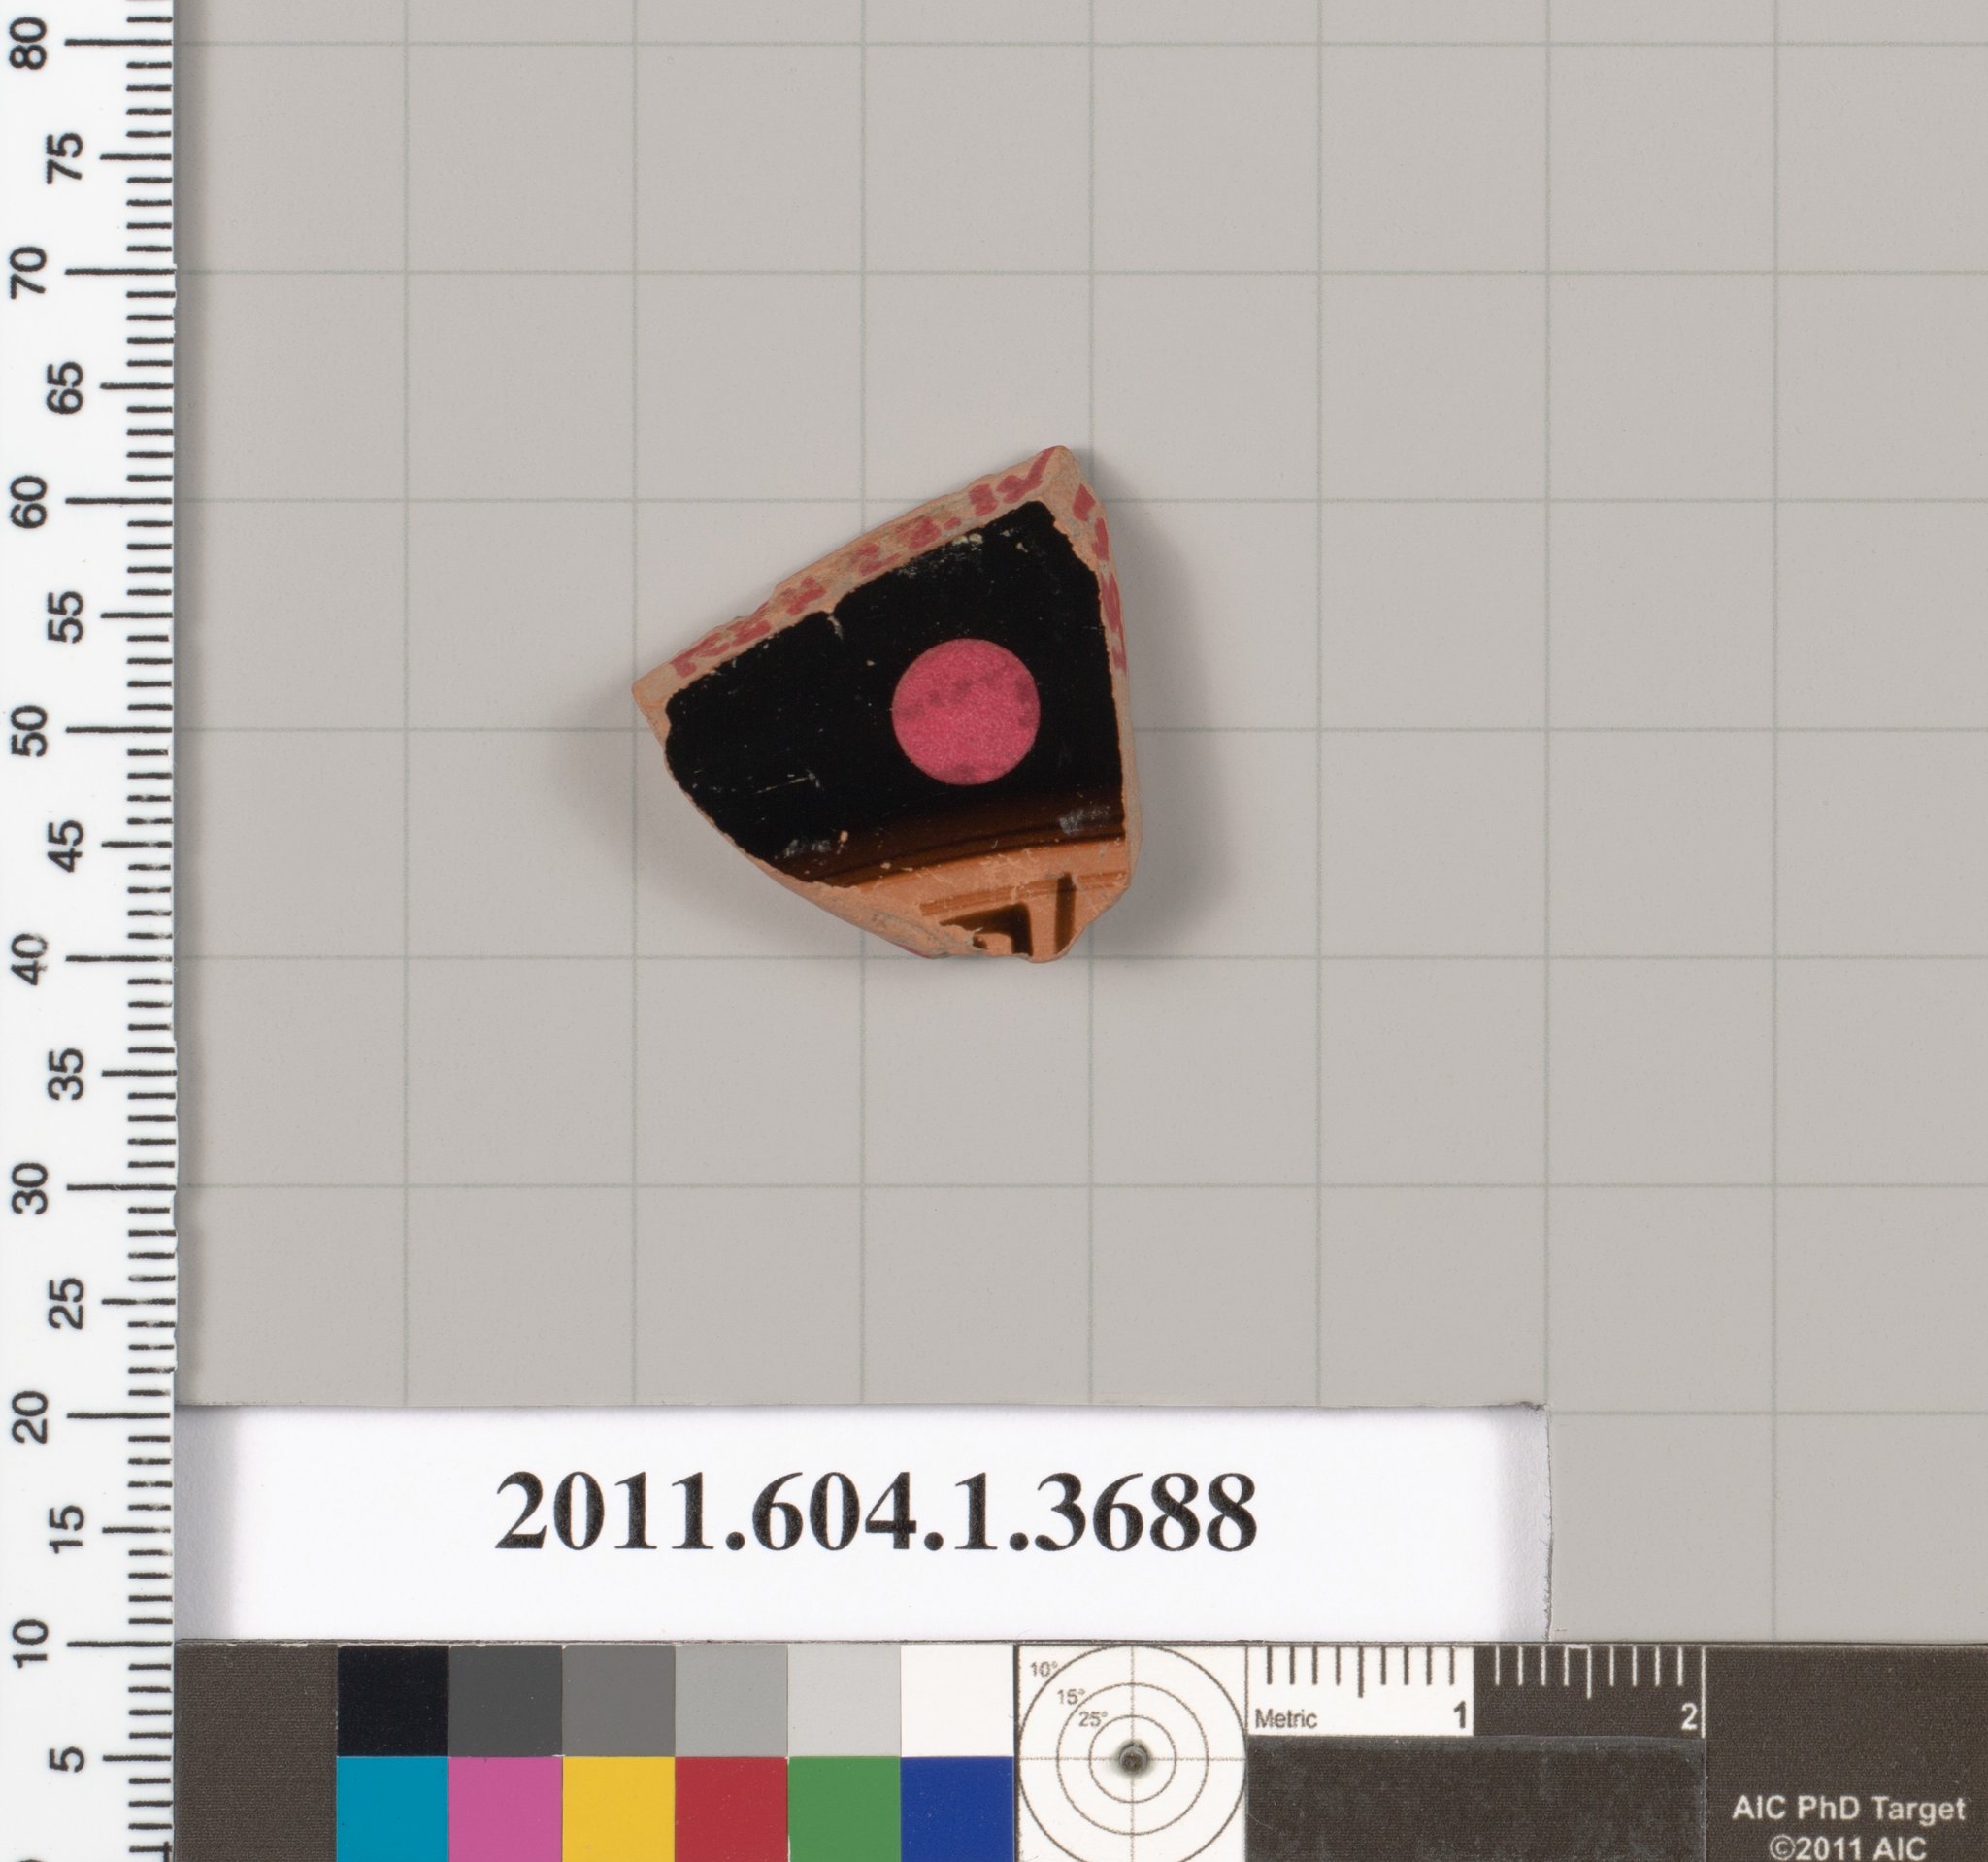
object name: kylix fragment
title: Terracotta fragment of a kylix (drinking cup)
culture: greek, attic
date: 490-480 BCE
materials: terracotta